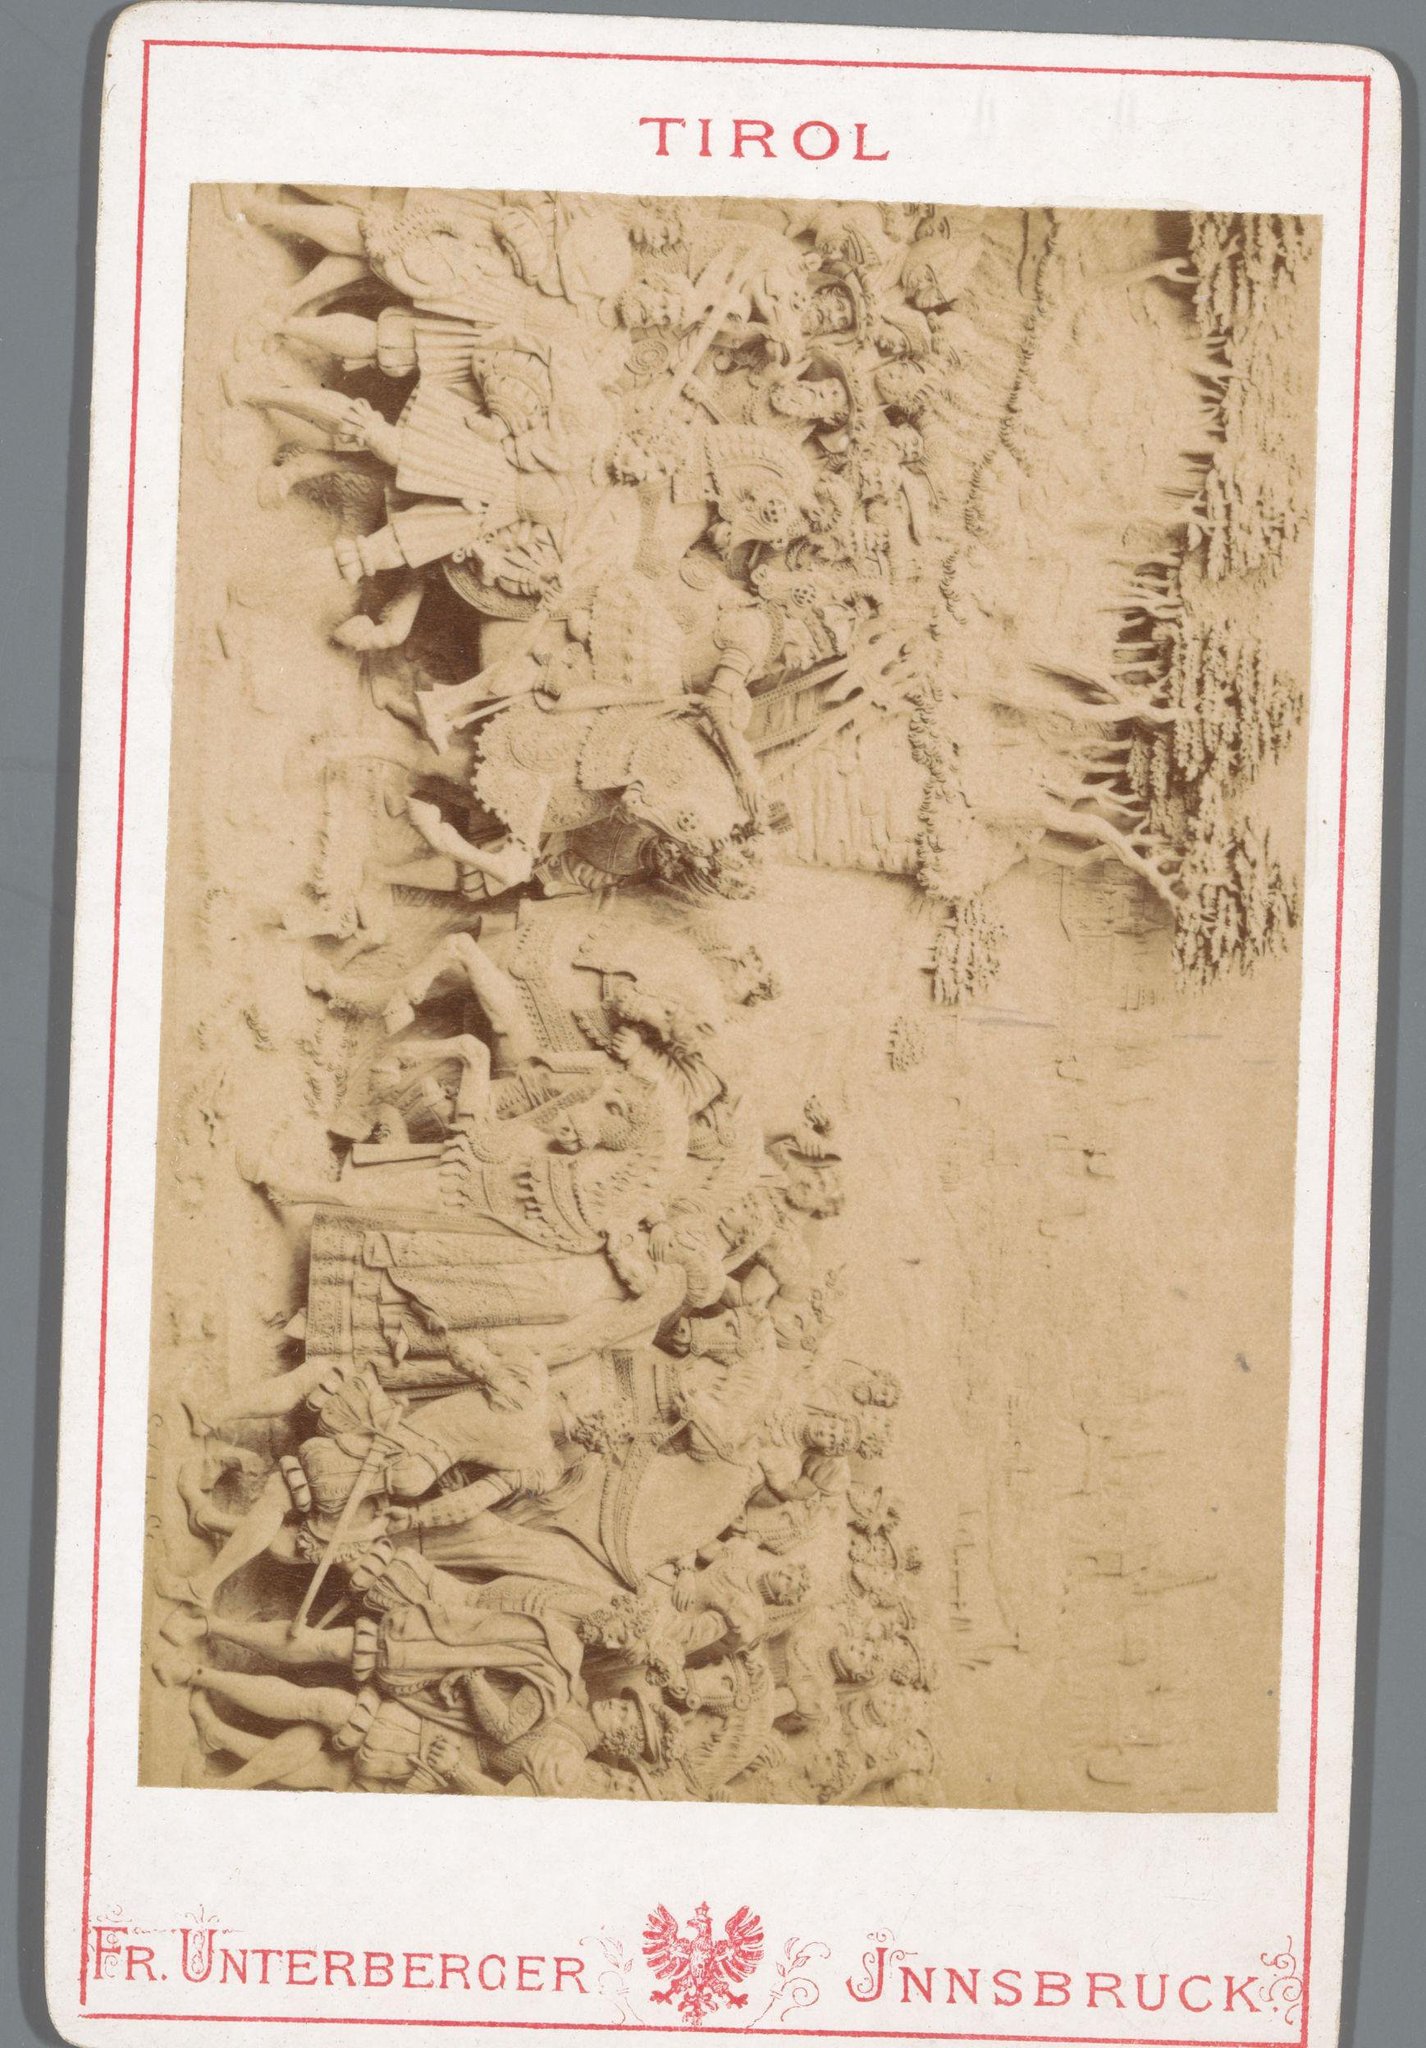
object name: carte de visite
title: Reliëf op de tombe van keizer Maximiliaan I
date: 1855-1867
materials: cardboard, paper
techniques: albumen print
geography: innsbruck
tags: grave, tomb, ruler, sovereign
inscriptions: number: ‘19’